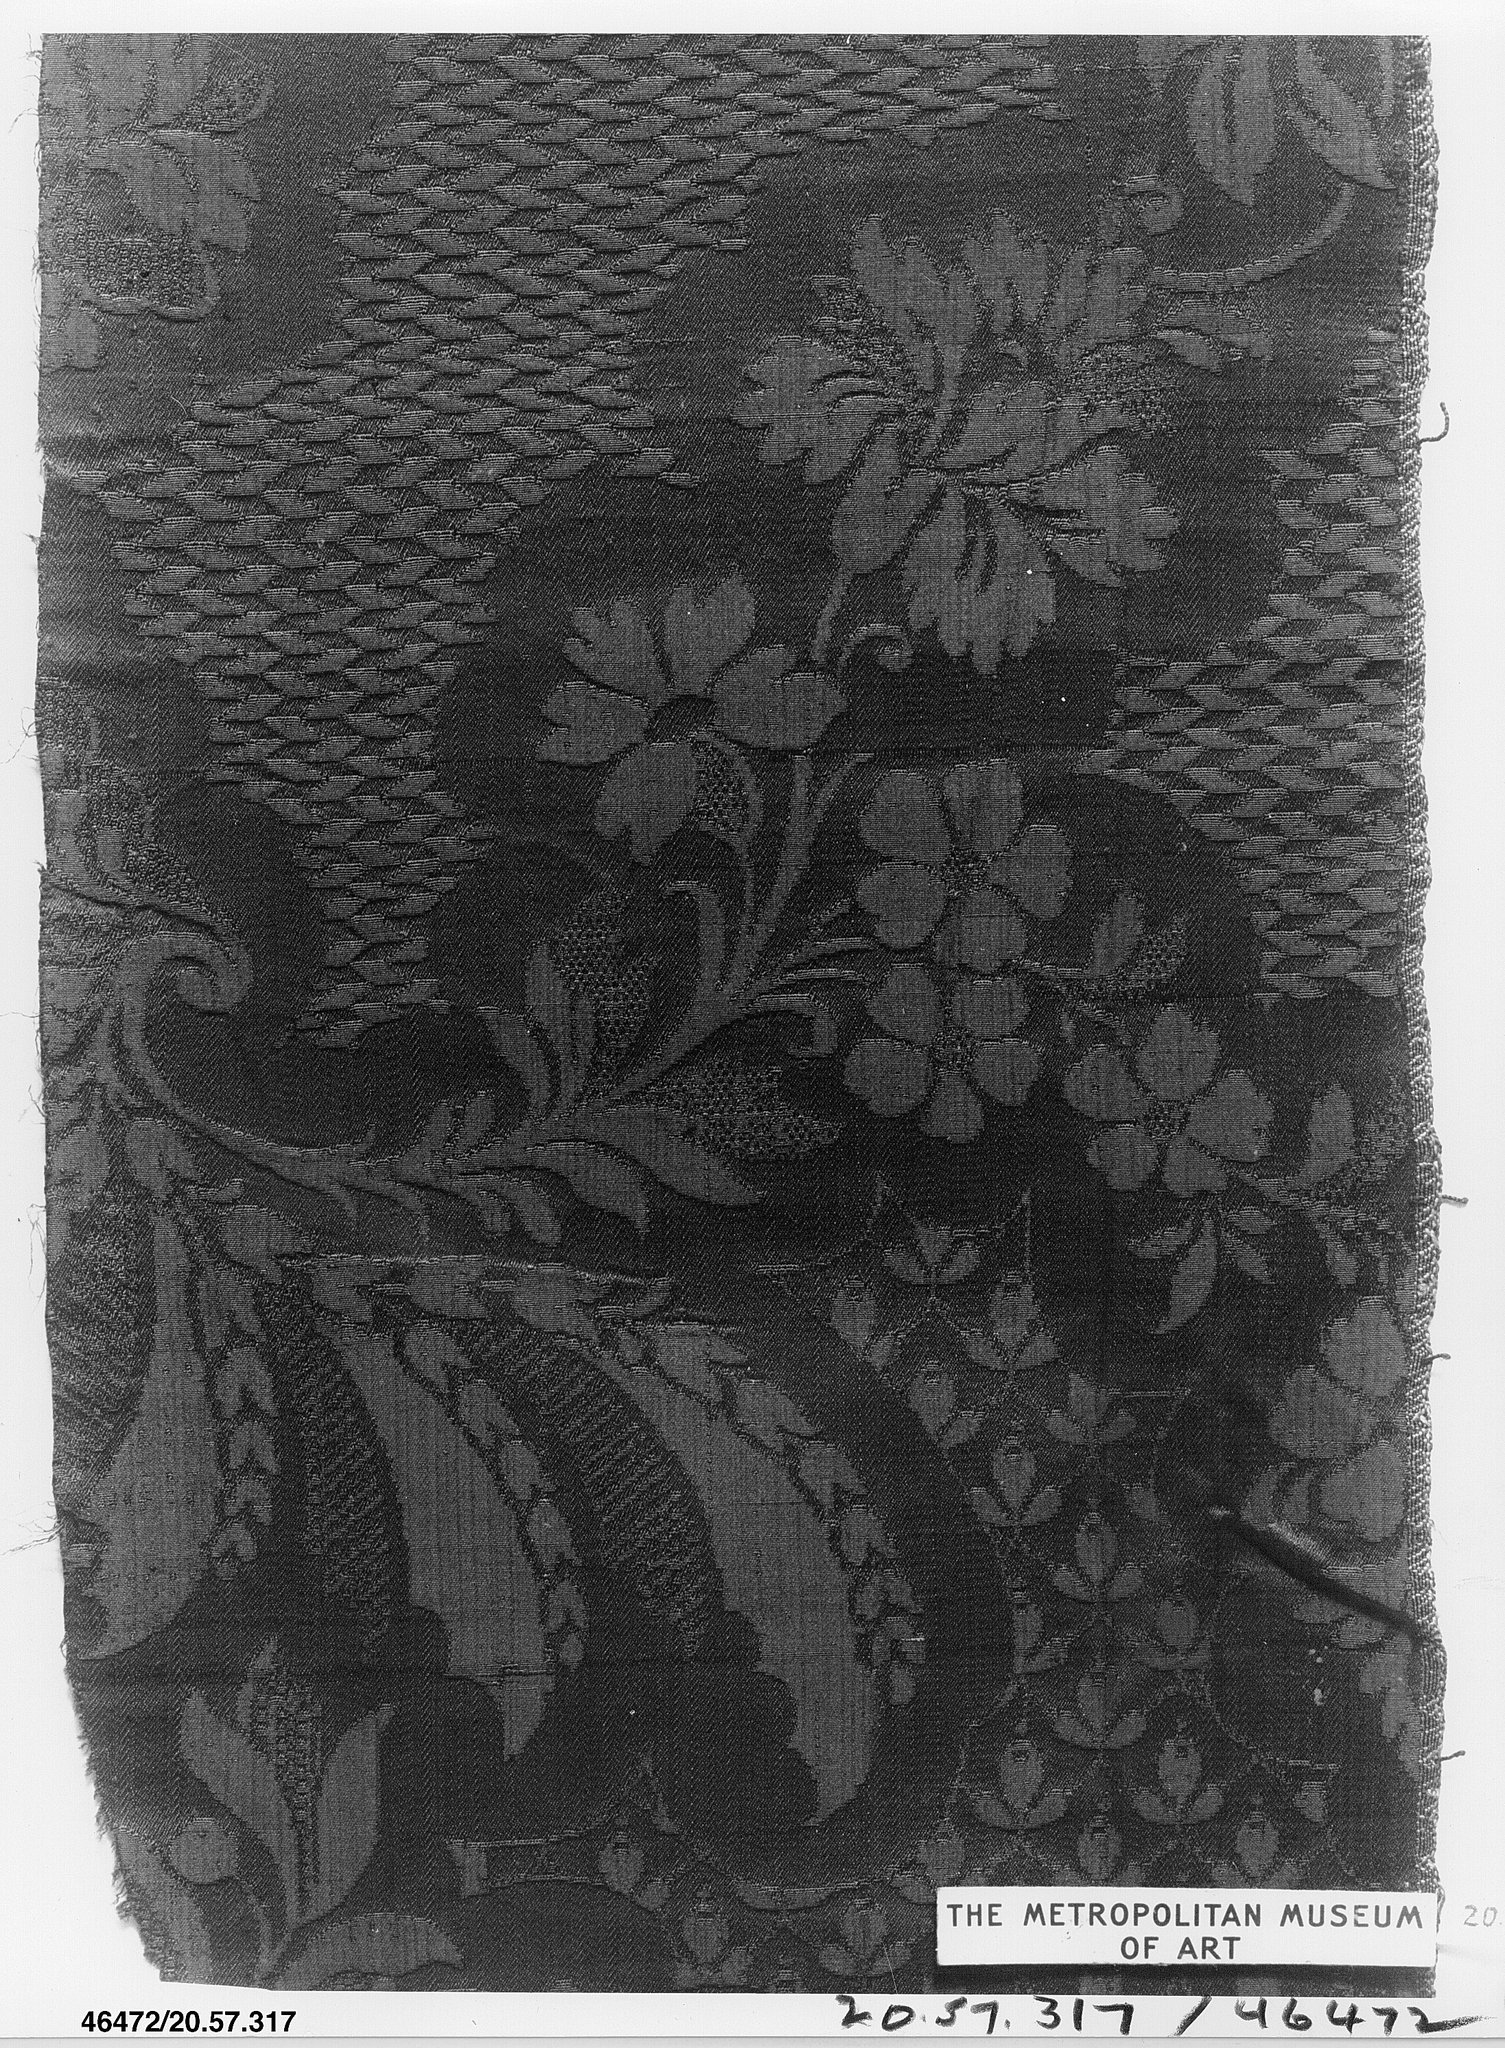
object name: piece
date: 1750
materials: silk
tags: flowers,leaves